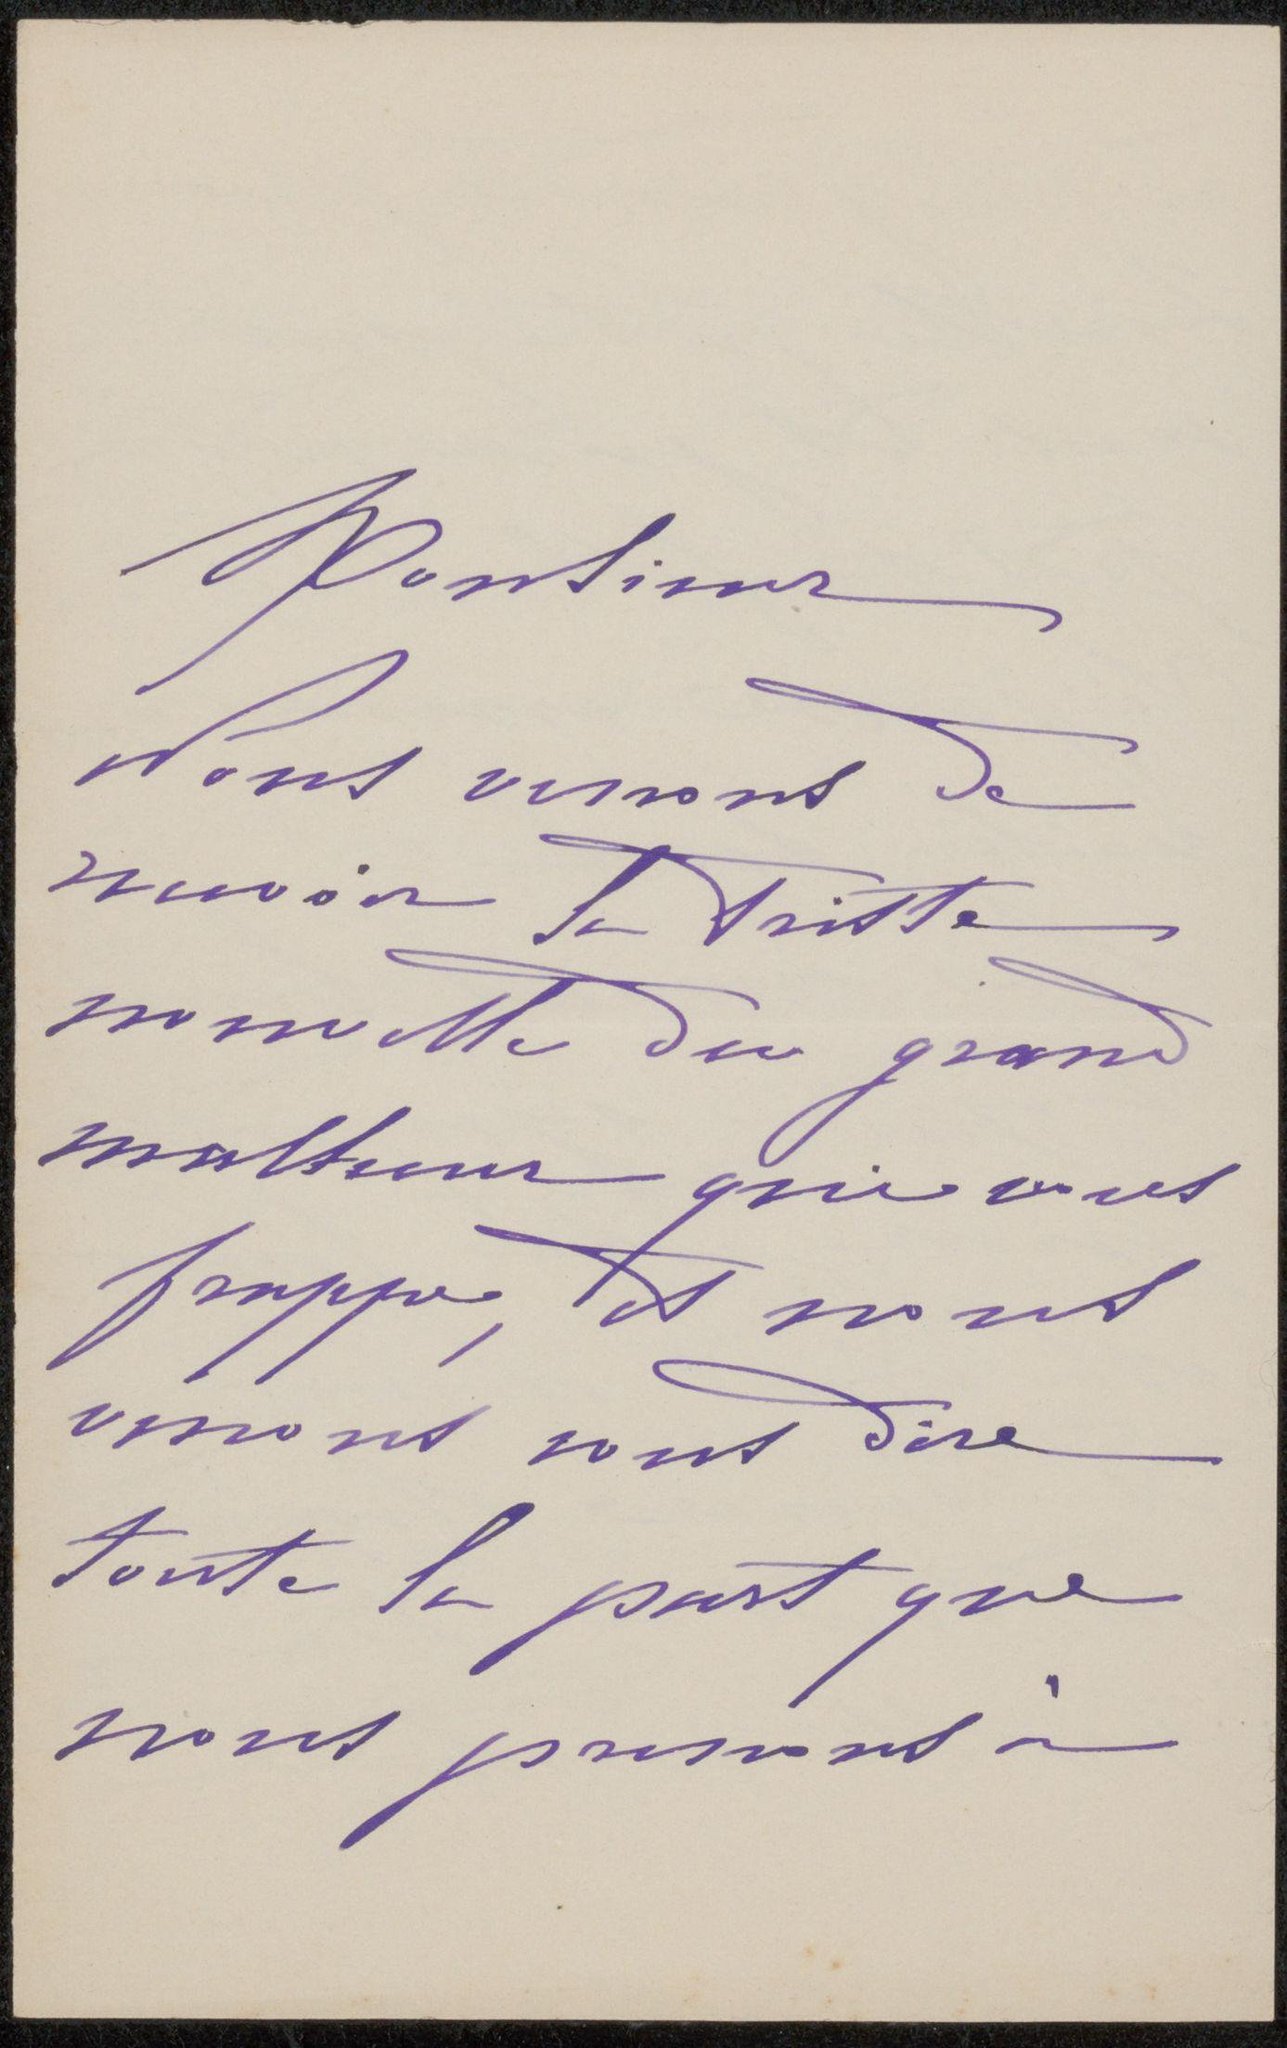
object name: letter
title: Brief aan Philip Zilcken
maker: Anonymous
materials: ink, paper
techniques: pen, writing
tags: voorburg, print maker, renée hélène laure zilcken, helène lambertine hauzeur, the hague, painter, draughtsman, philip zilcken, passions, emotions, affections, christian religion